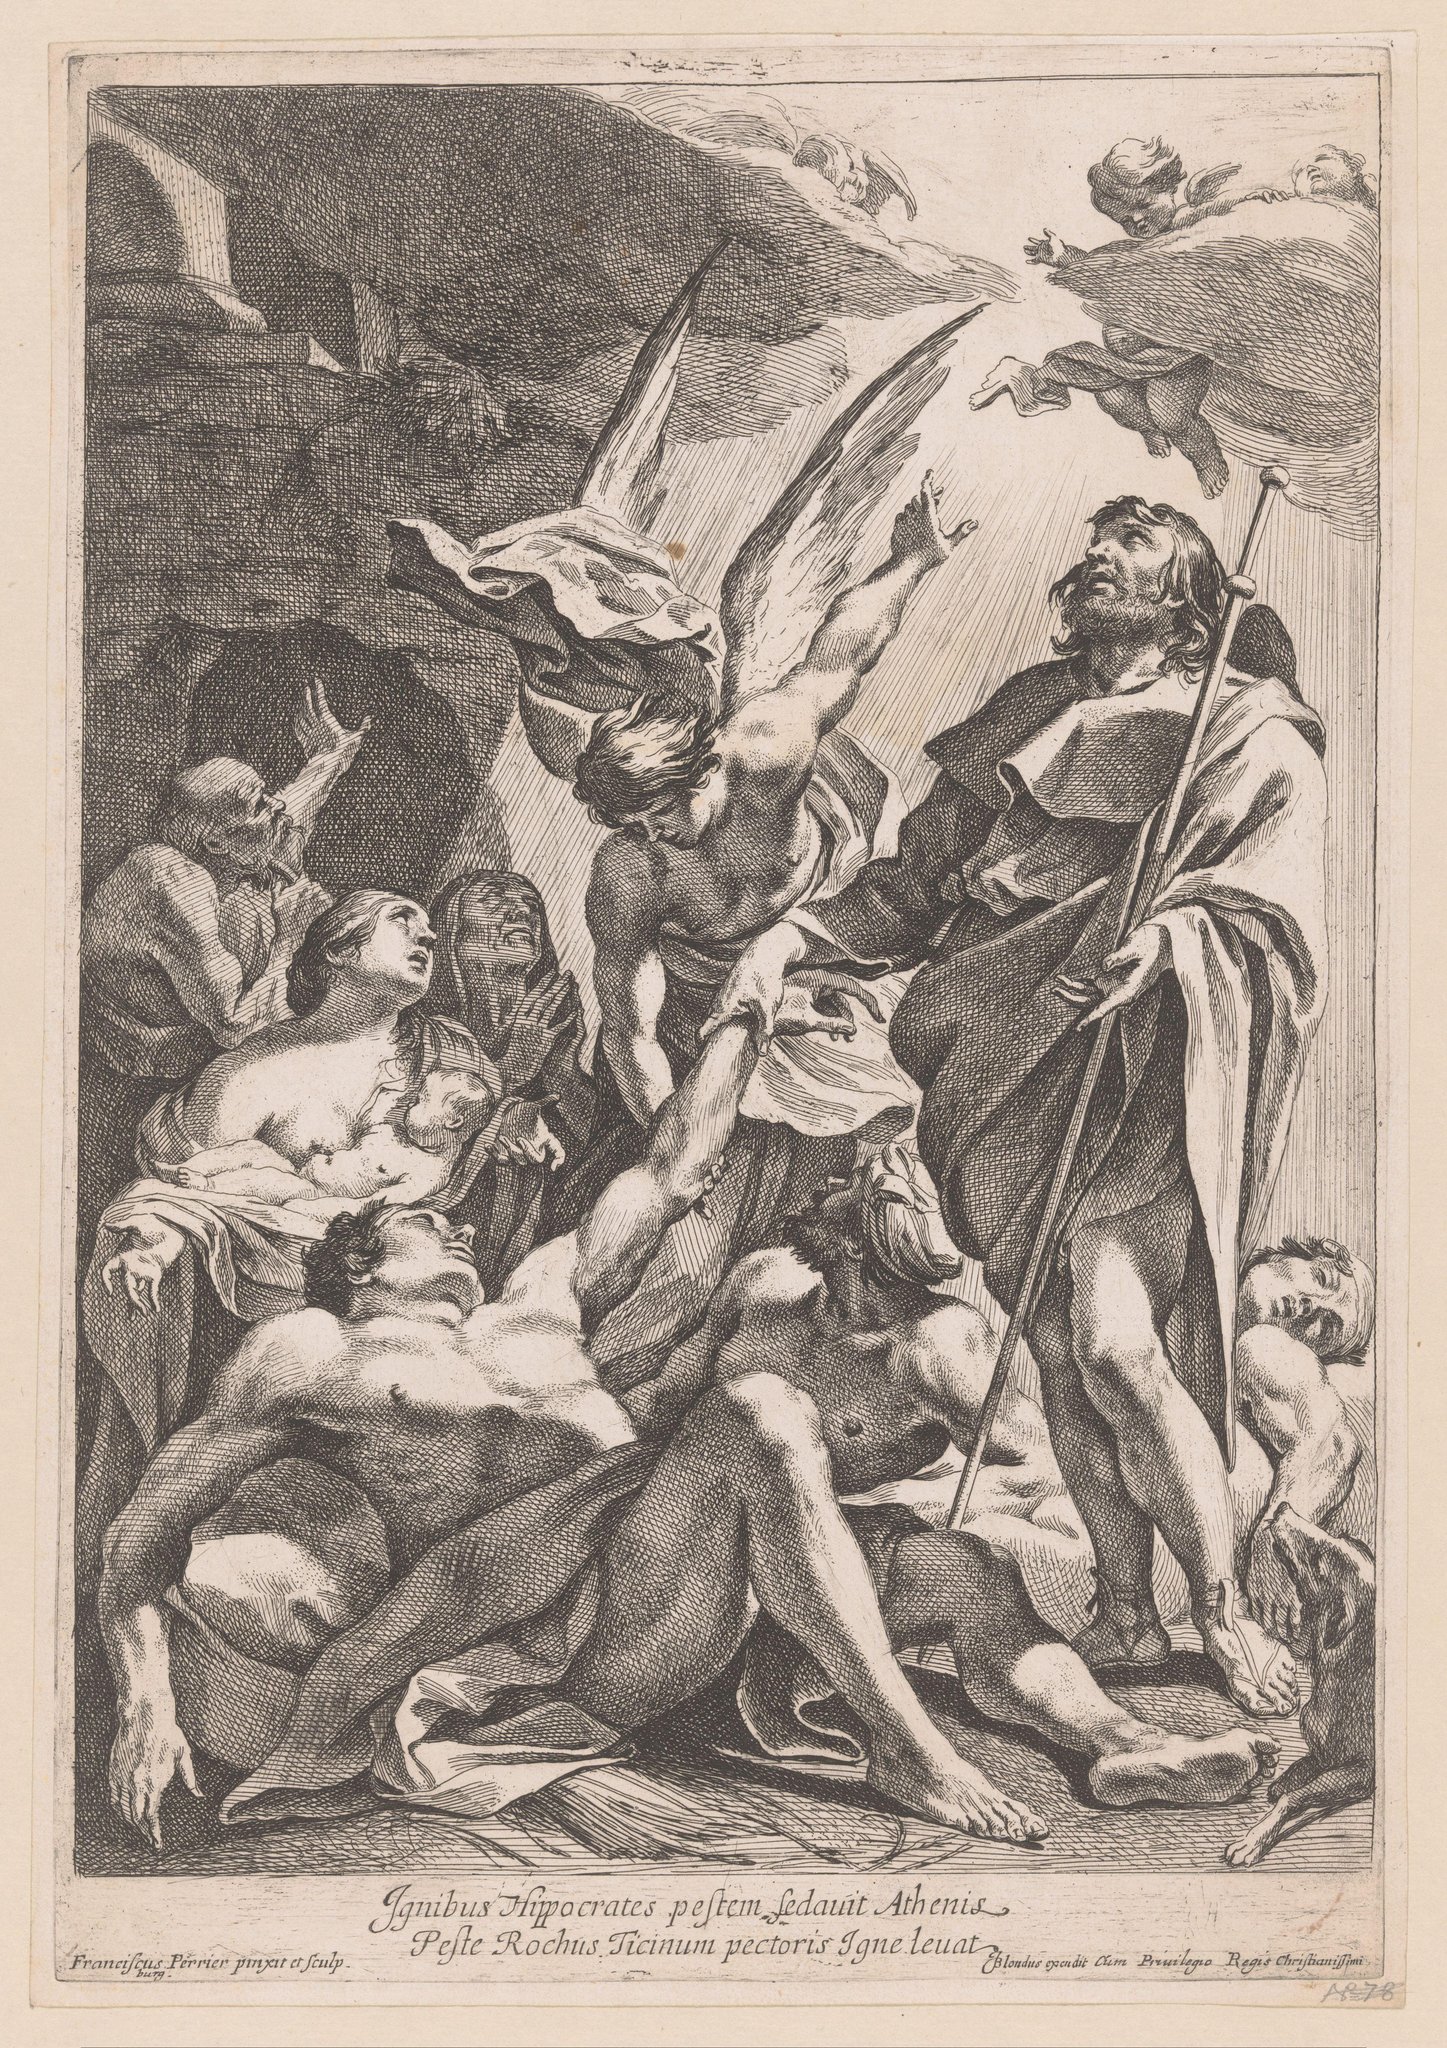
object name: print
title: Heilige Rochus geneest de pestlijders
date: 1600-1650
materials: paper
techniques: etching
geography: france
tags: st. roch heals (or administers to) the plague-stricken in a hospital, plague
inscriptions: collector's mark: Lugt 240